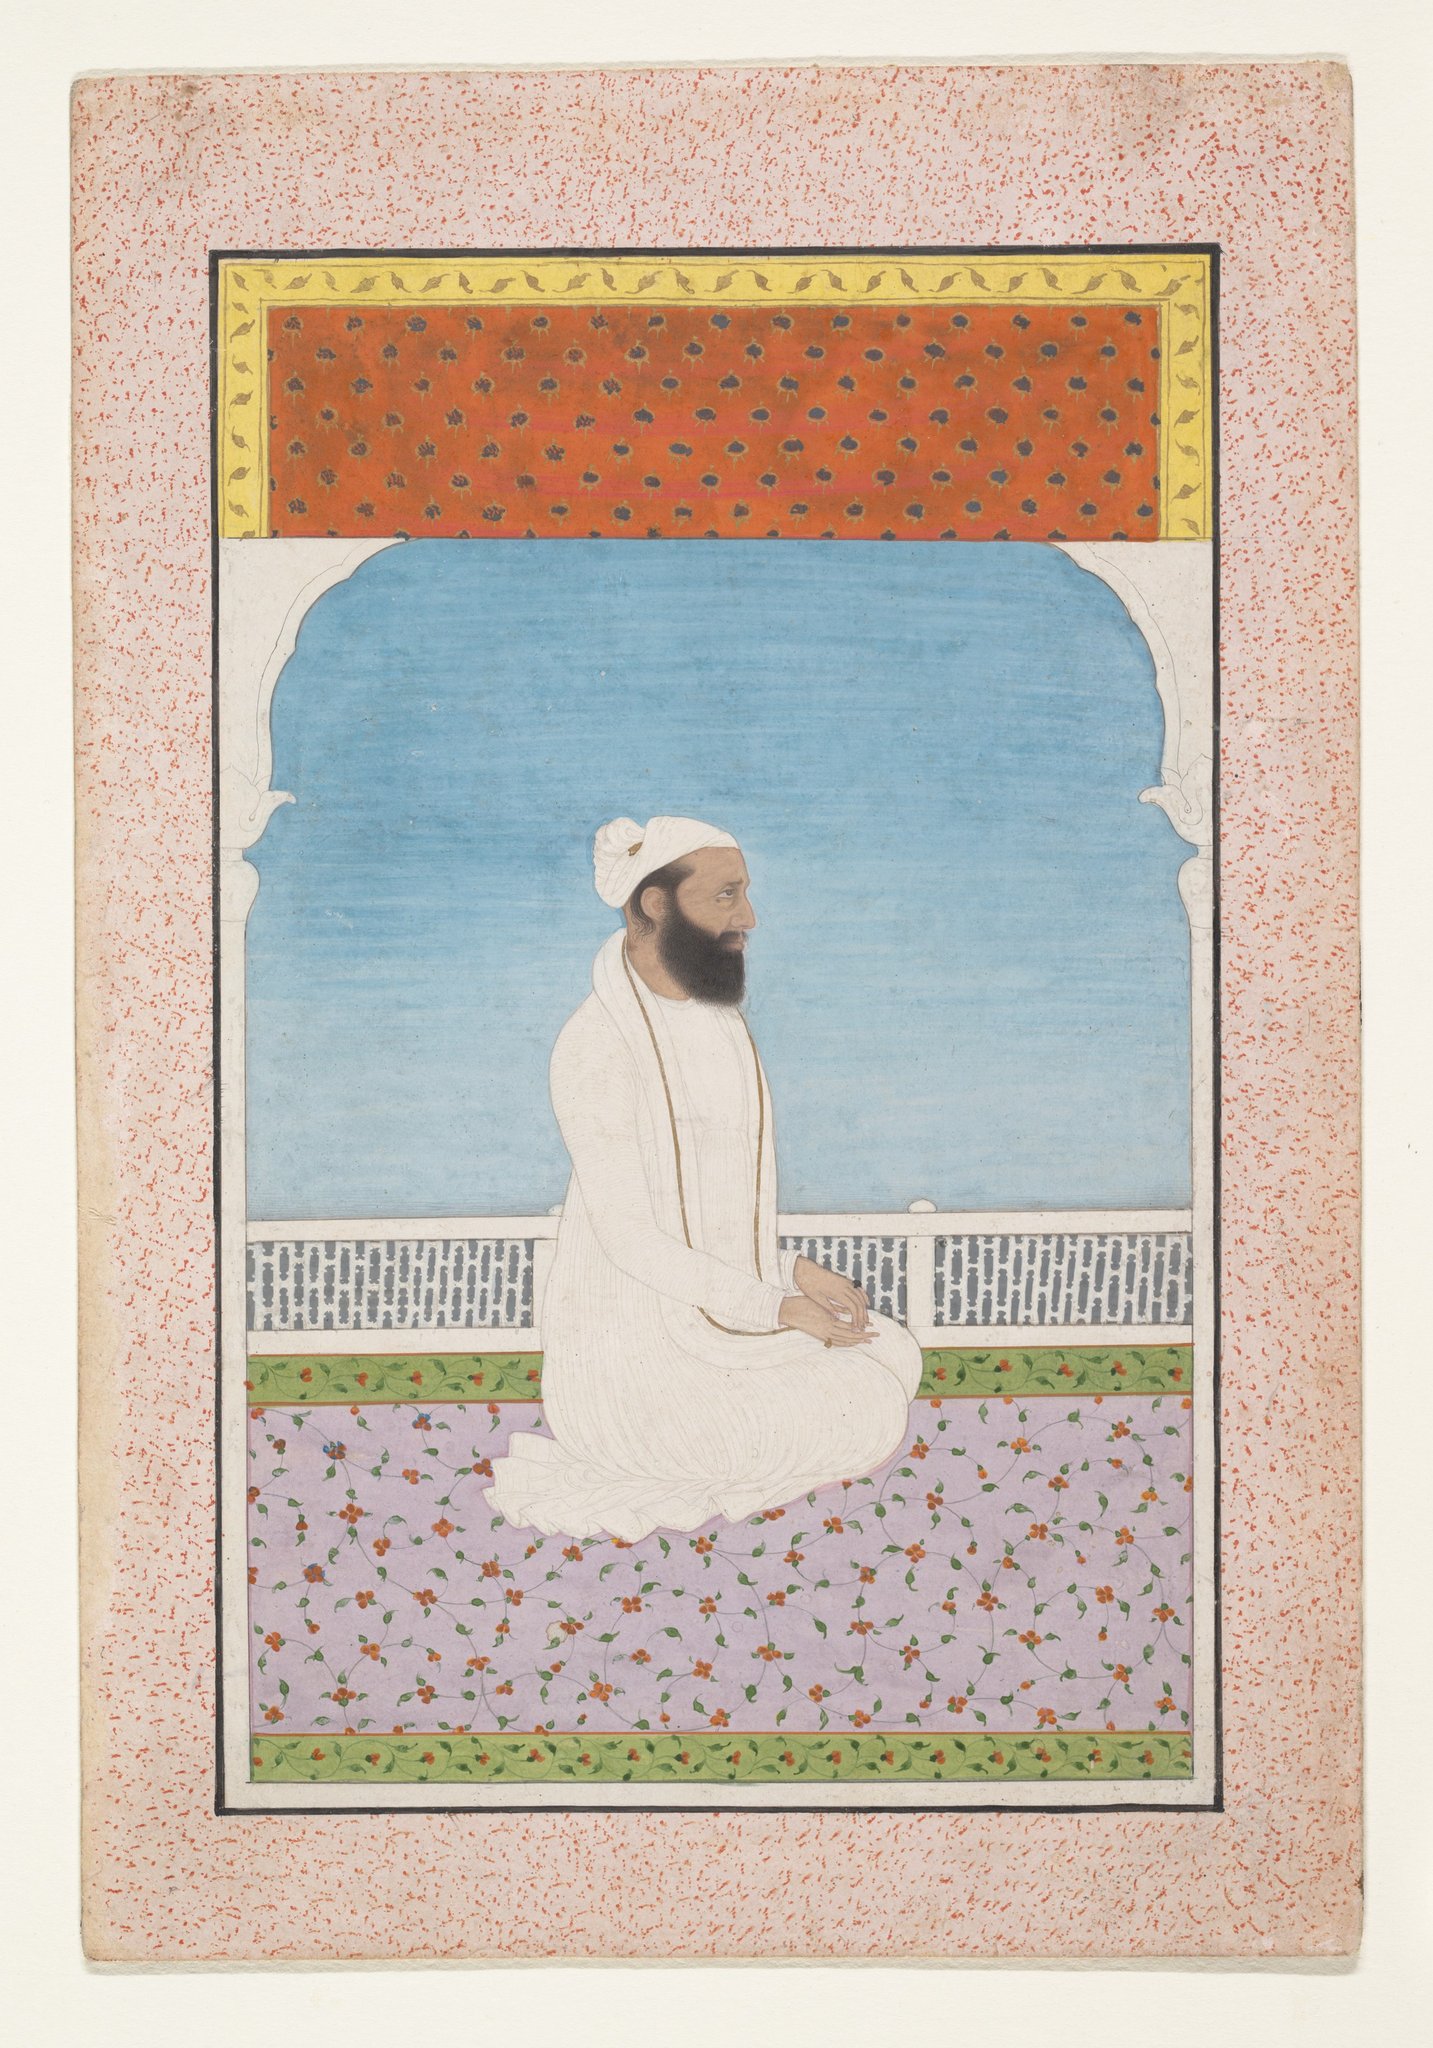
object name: painting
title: A Holy Man Seated on a Terrace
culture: indian, kangra, punjab hills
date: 1850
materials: ink, paper, watercolor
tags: men